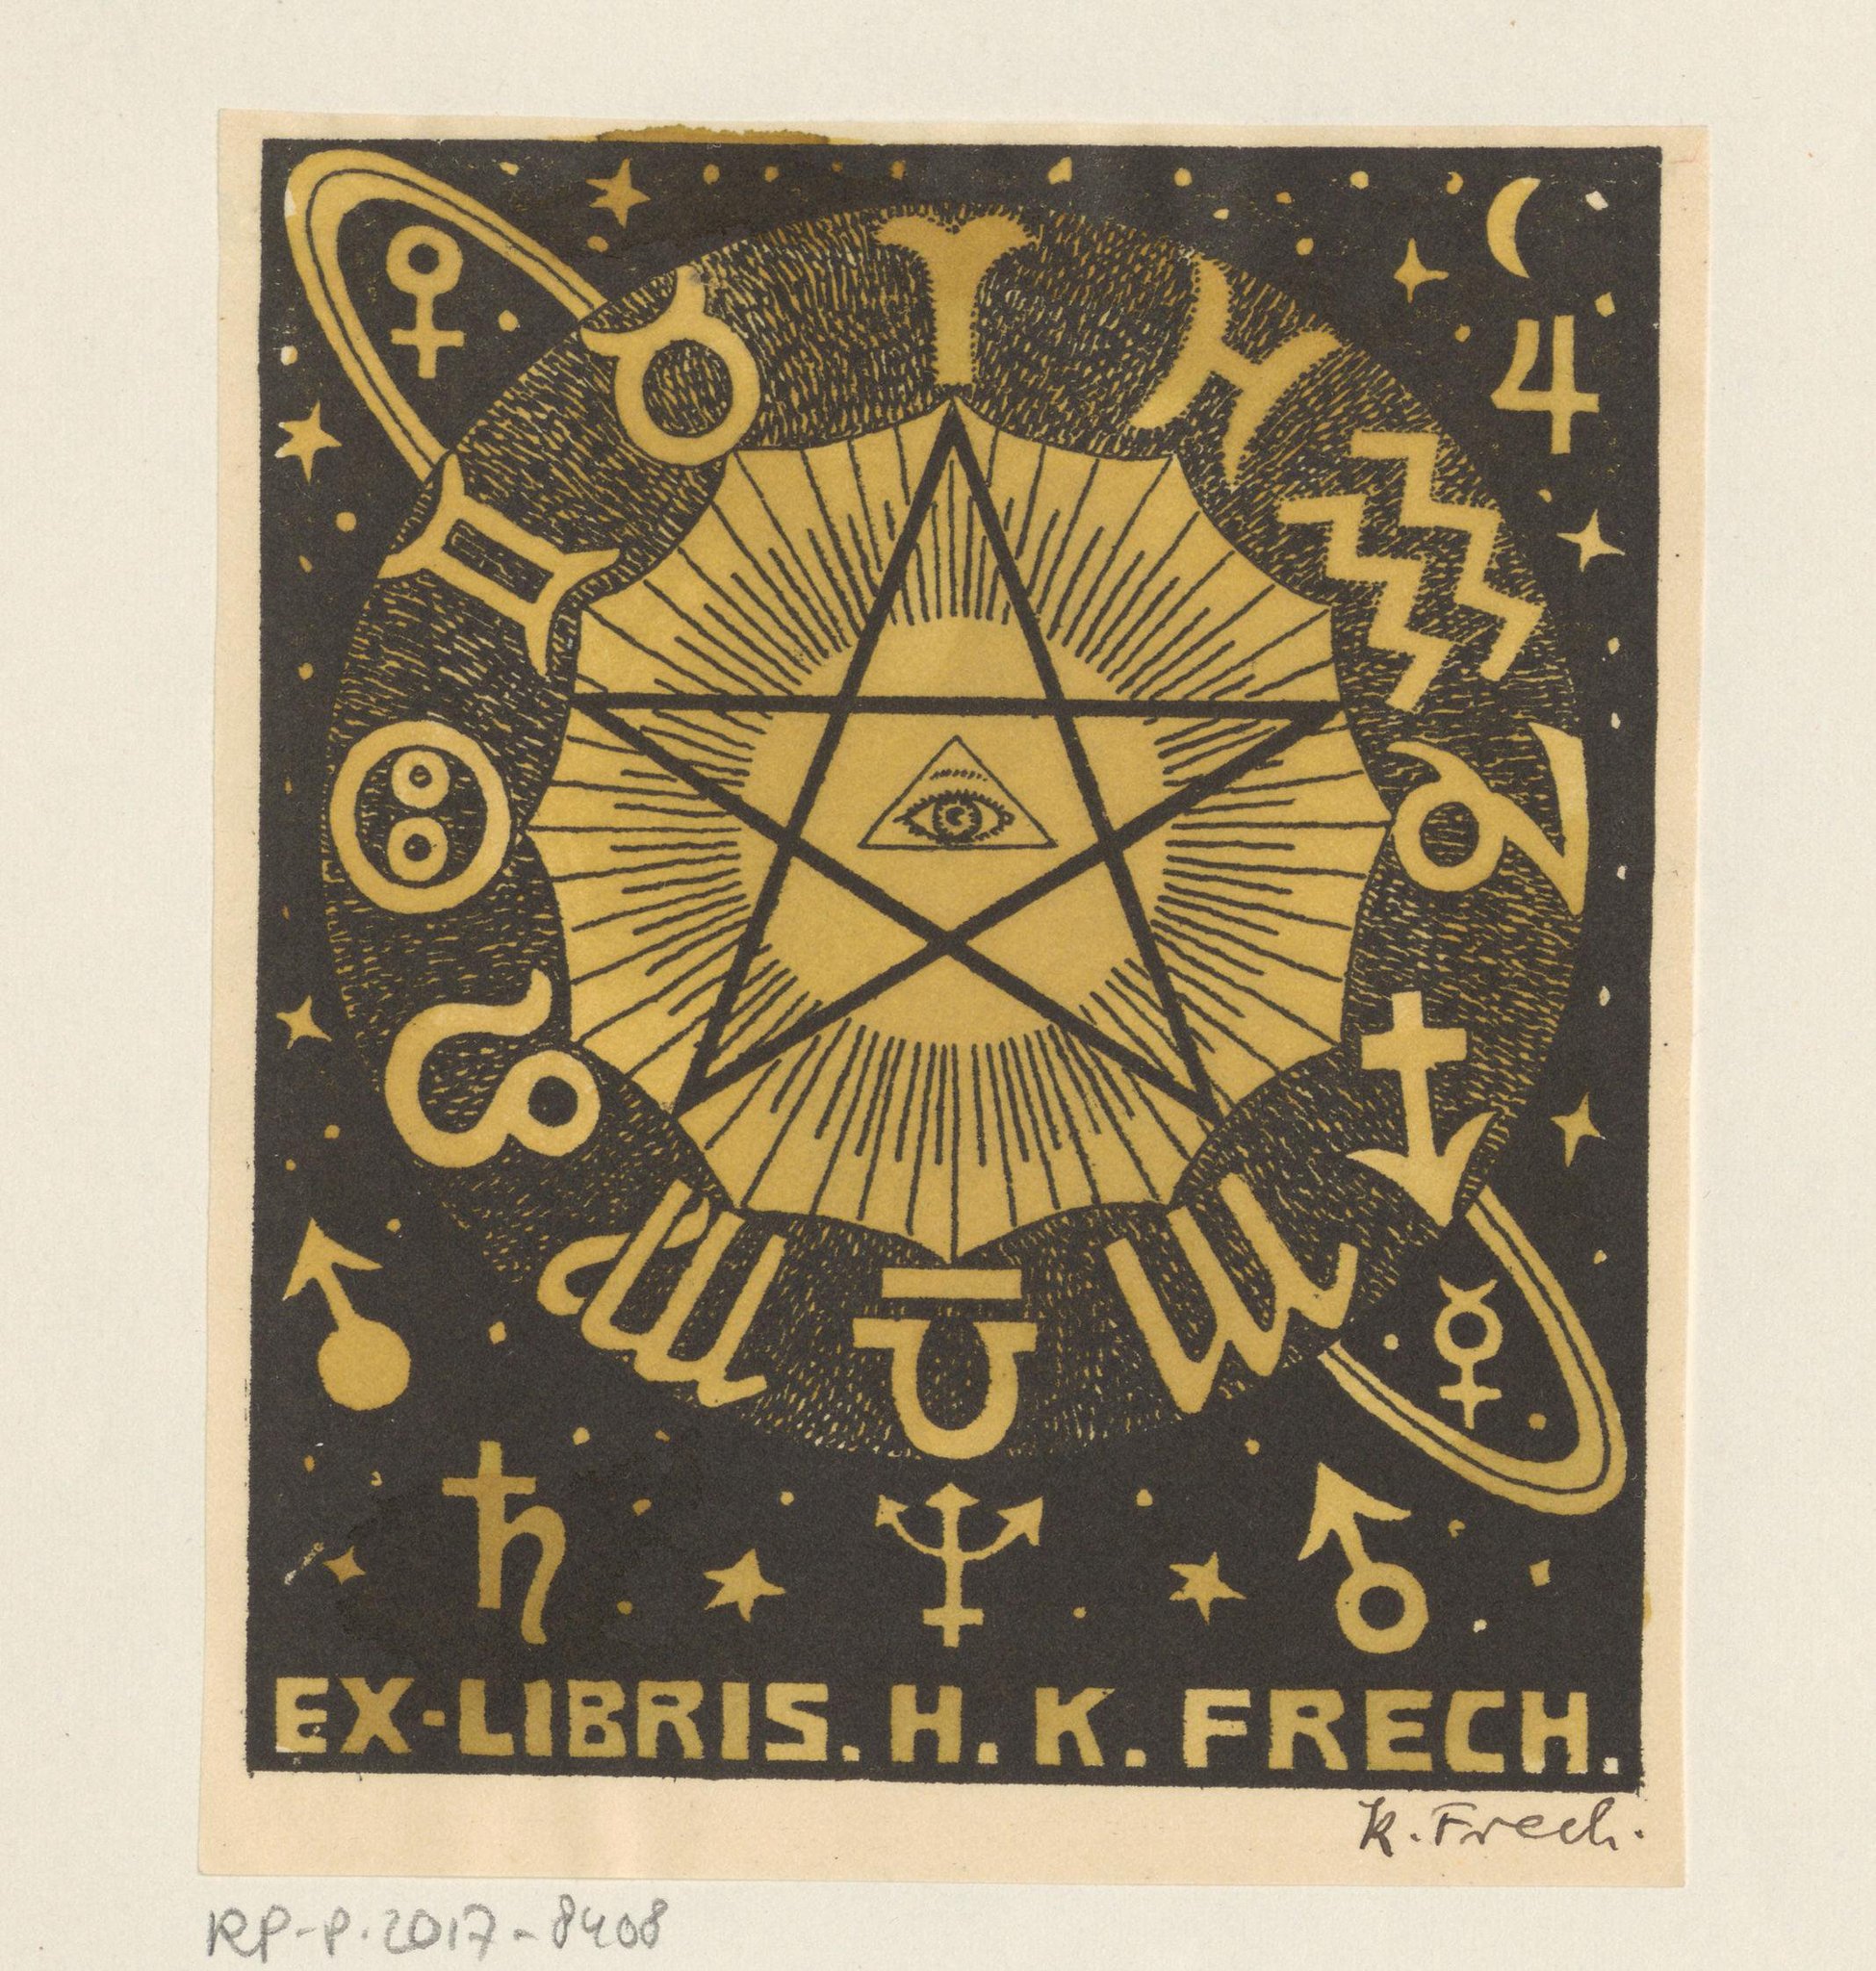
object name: bookplate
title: Ex libris van H.K. Frech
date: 1893-1945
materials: paper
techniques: hand coloring, printing block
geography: bratislava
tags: magic, supernaturalism, occultism, zodiac; the twelve zodiacal signs together, the all-seeing eye, triangle with eye ~ symbol of god the father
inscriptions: signature: ‘K. Frech’, workshop stamp: ‘Karl Frech/ Maler-Graphiker/ Bratislava - Pressburg Simonyi Ivan Rad.’